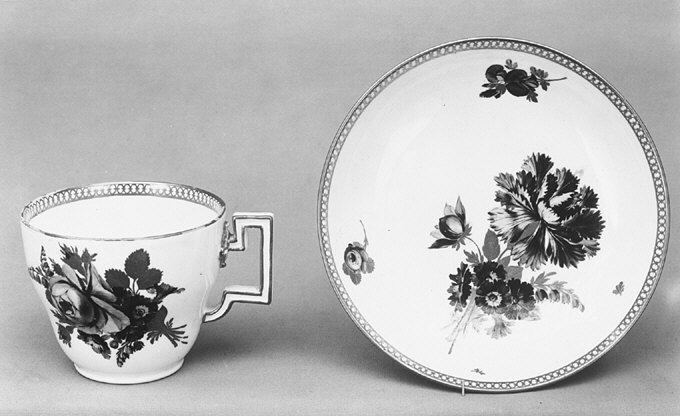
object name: saucer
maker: meissen manufactory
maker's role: manufactory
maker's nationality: german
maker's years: 1710-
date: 1796-1814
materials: hard paste porcelain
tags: flowers